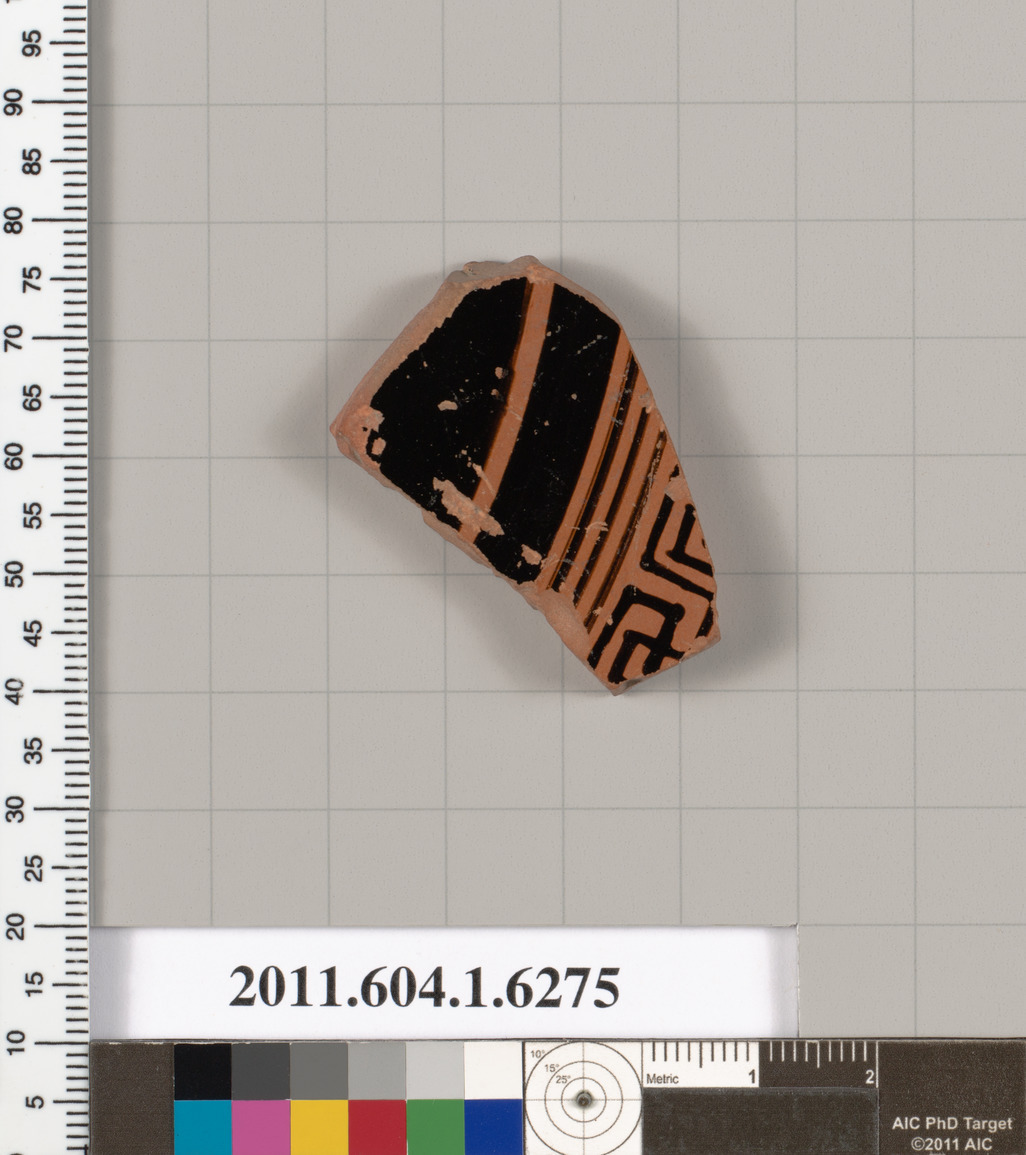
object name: kylix fragment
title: Terracotta fragment of a kylix (drinking cup)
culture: greek, attic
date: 500-480 BCE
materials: terracotta